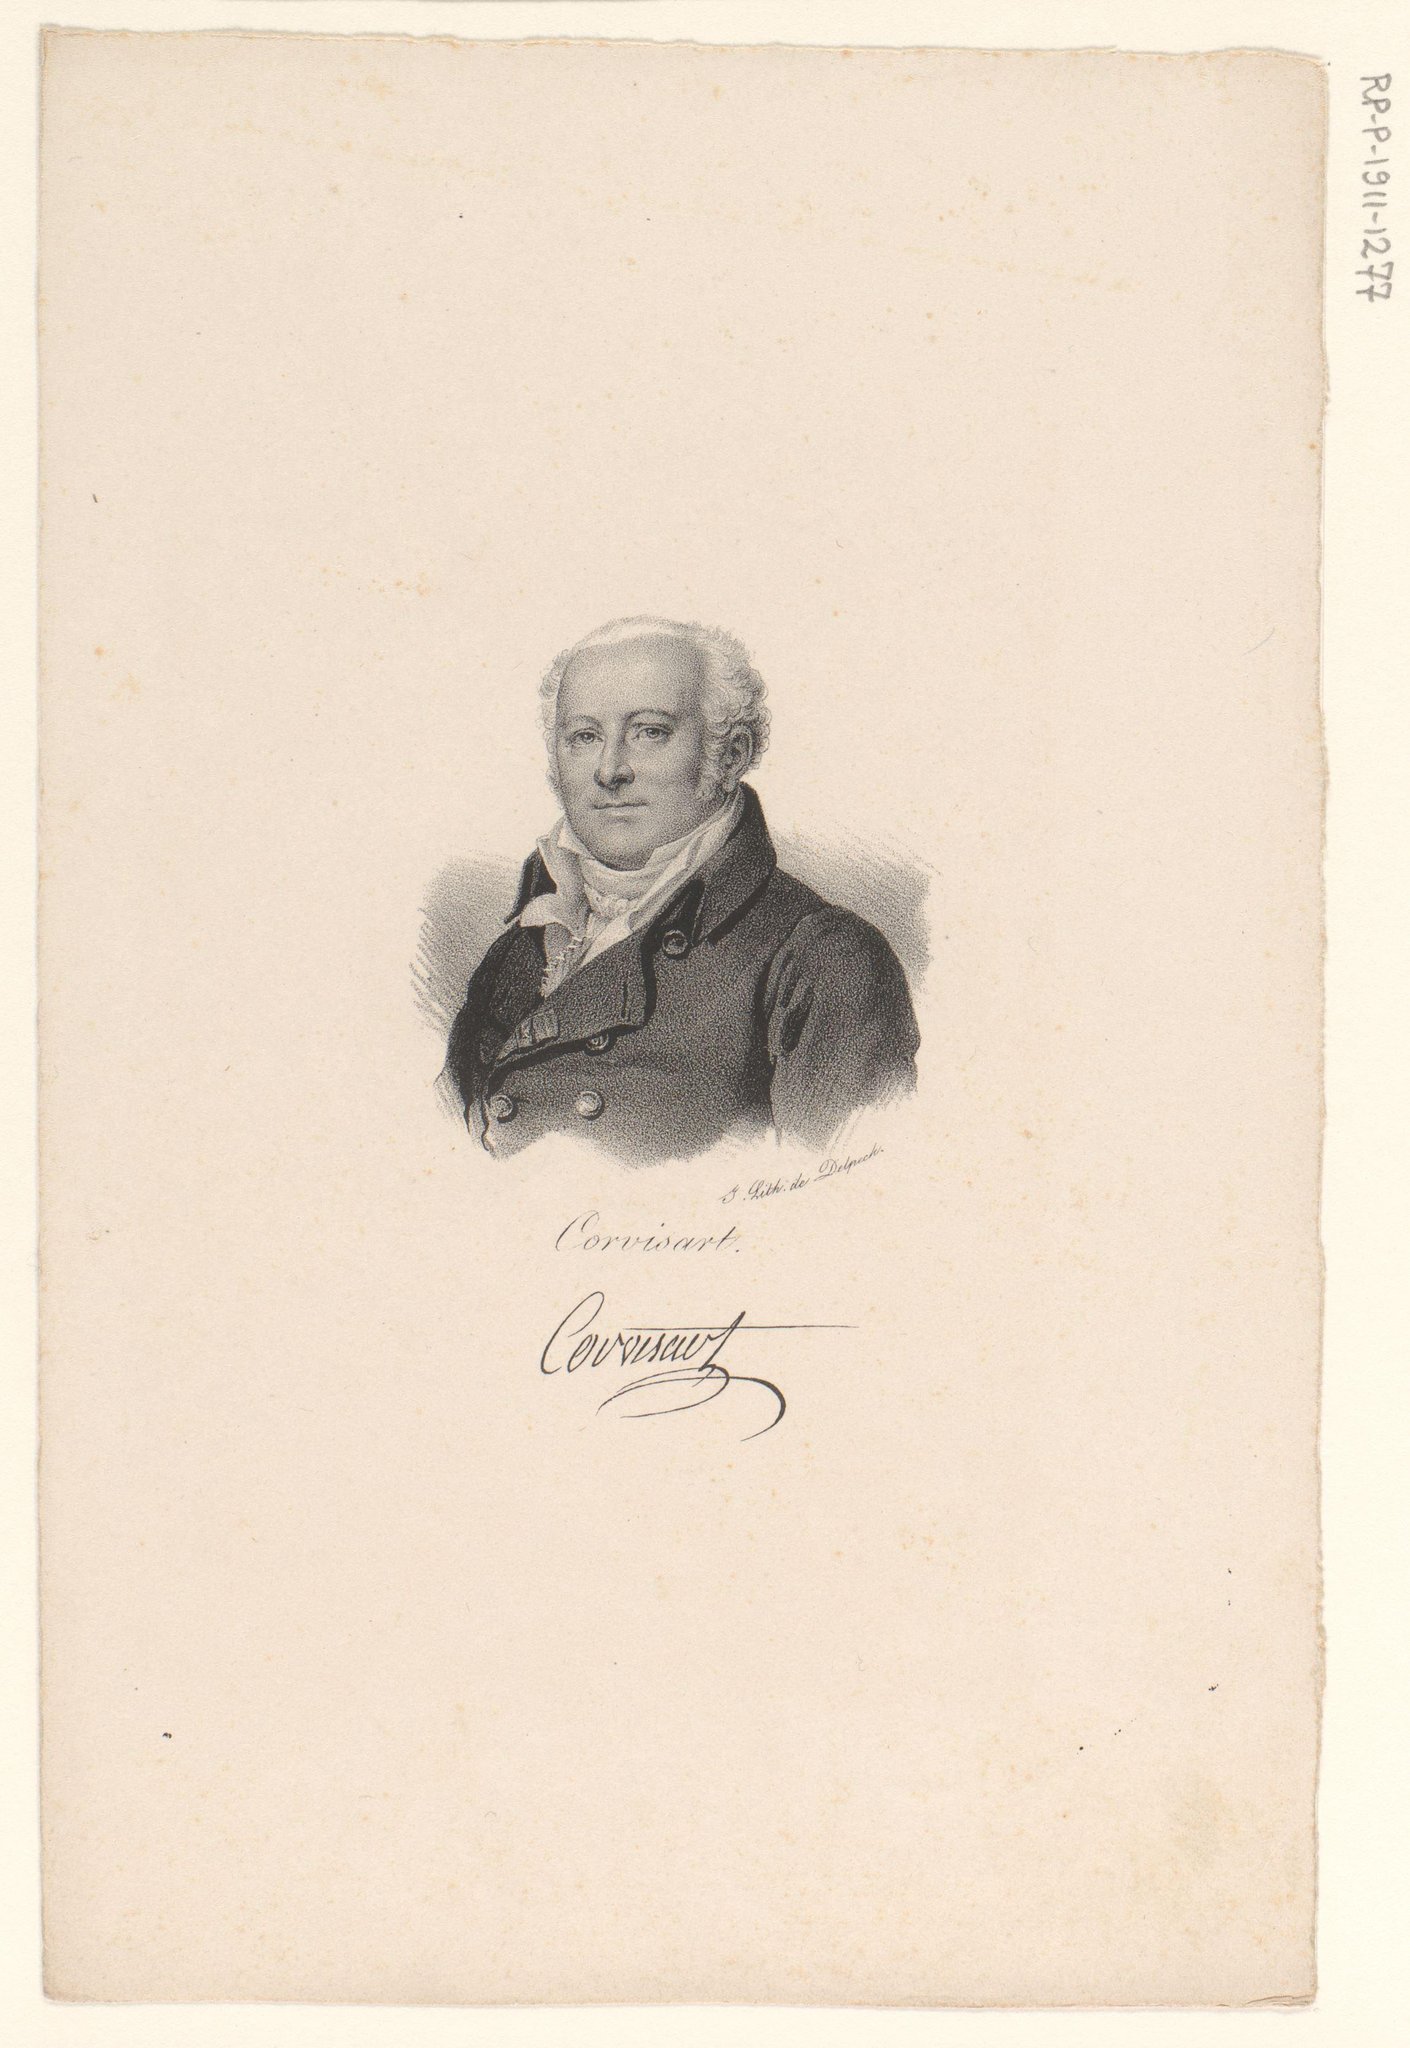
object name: print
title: Corvisart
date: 1818-1842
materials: paper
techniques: lithograph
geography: paris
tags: historical persons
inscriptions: collector's mark: Lugt 2228a